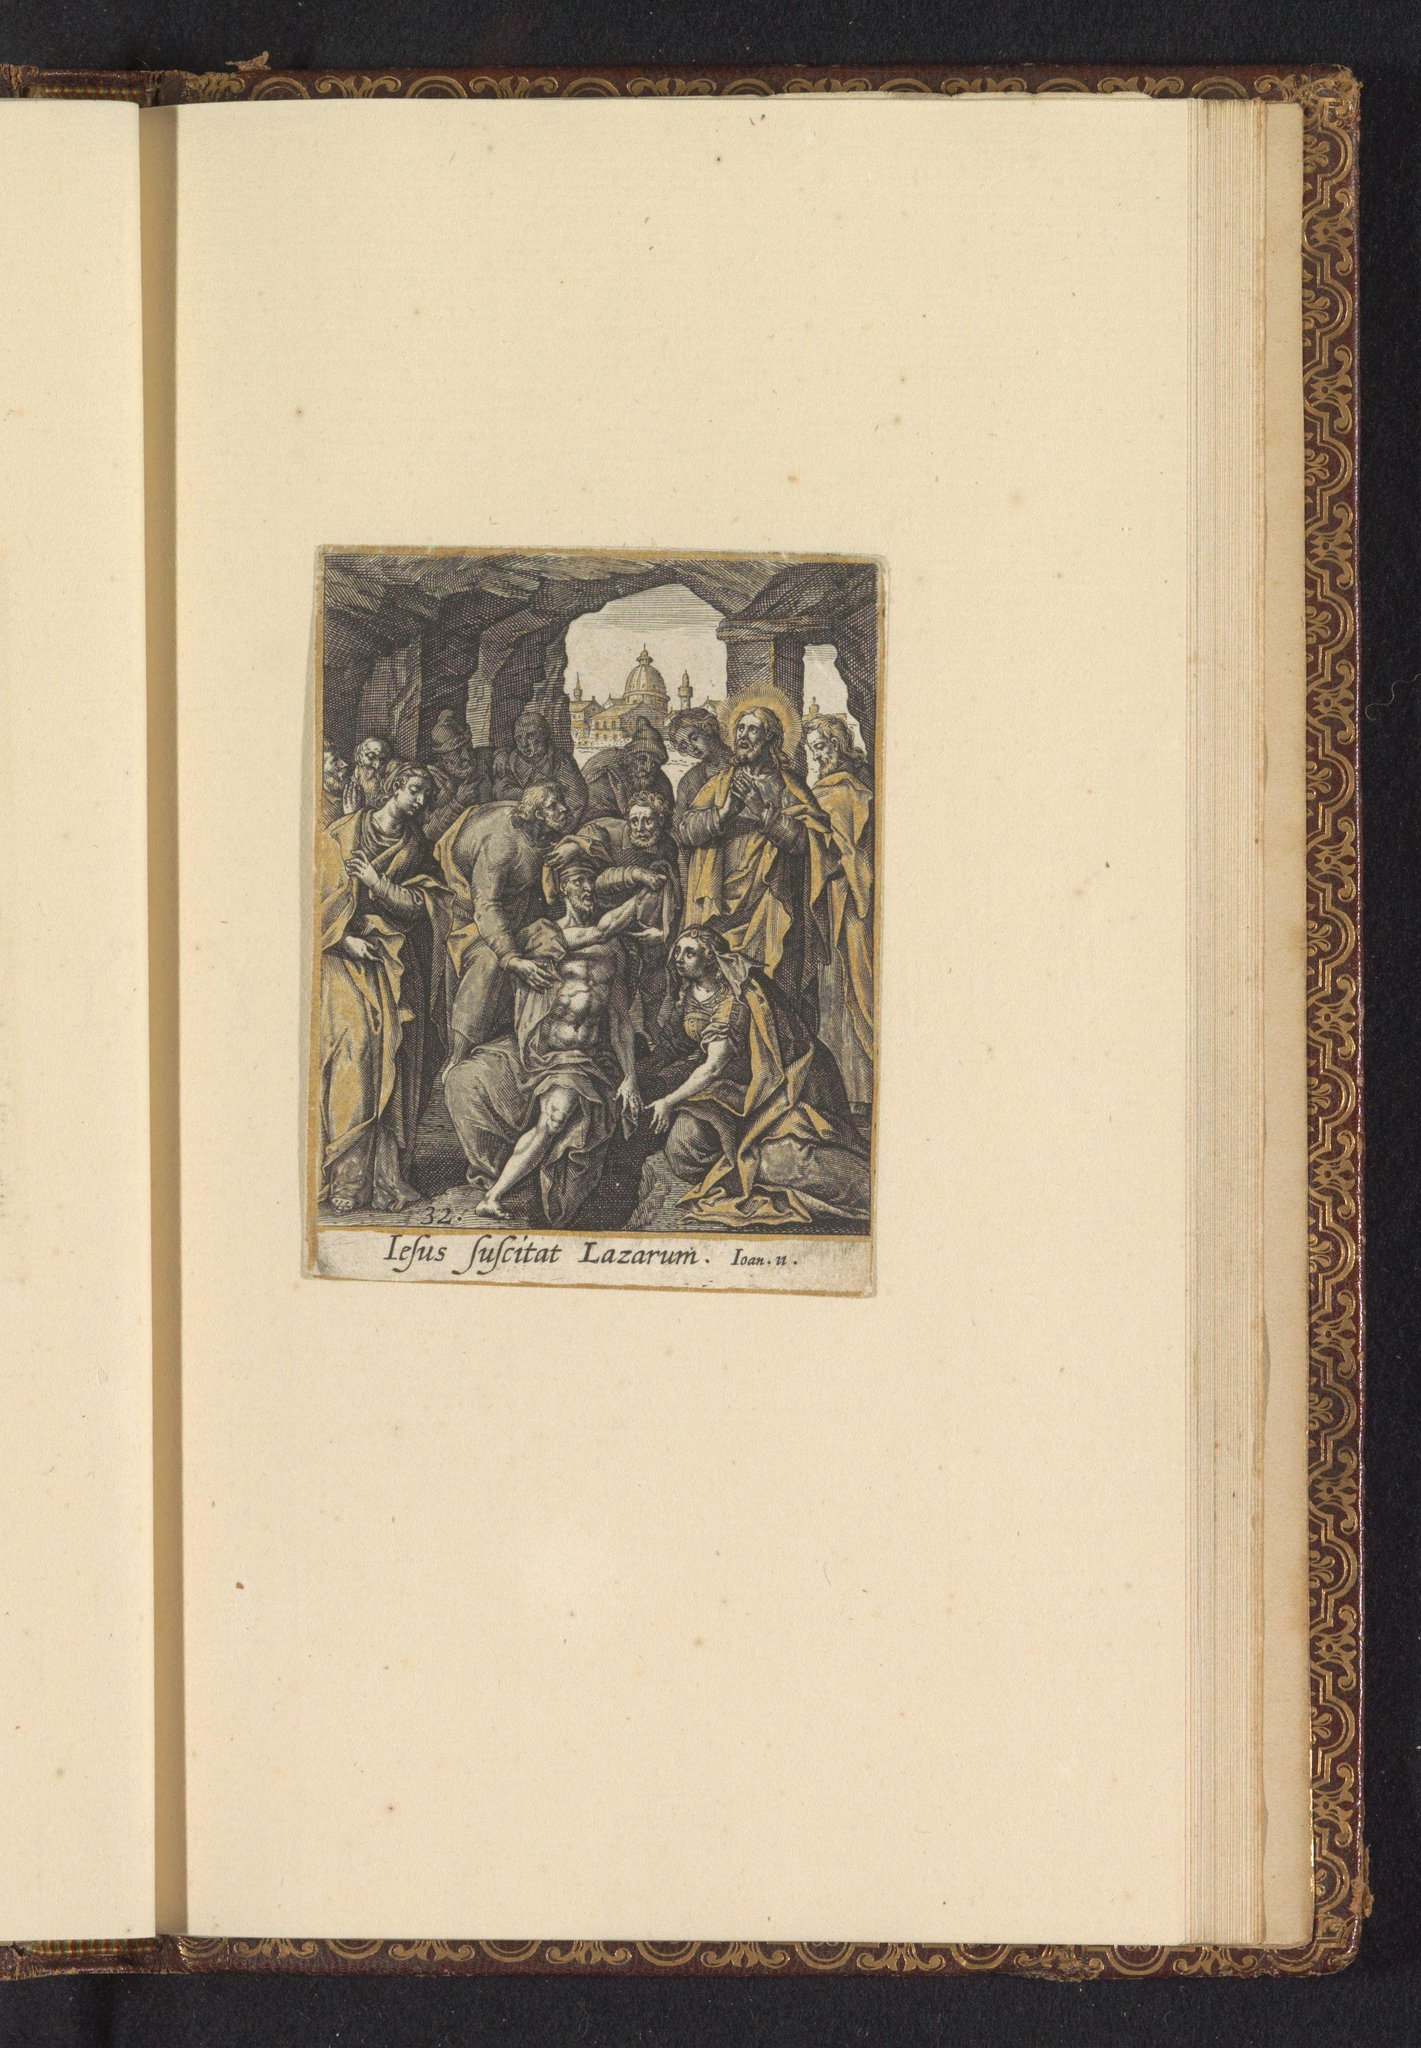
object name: print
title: Opwekking van Lazarus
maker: adriaen collaert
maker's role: draughtsman, print maker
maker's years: 1560-1618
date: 1580-1590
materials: gold, paper, silver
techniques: engraving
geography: antwerp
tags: the raising of lazarus ('lazarus, come out')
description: De gravures van beide reeksen zijn door dezelfde hand gehoogd met goud en zilver. De eerste reeks van 34 (van 35) gravures is een verkleinde versie naar prenten uit een reeks naar Maarten de Vos (nrs. 2-28, 31-33) met toevoeging van drie scènes uit de Wonderen van Christus (nrs. 26, 28, 30).